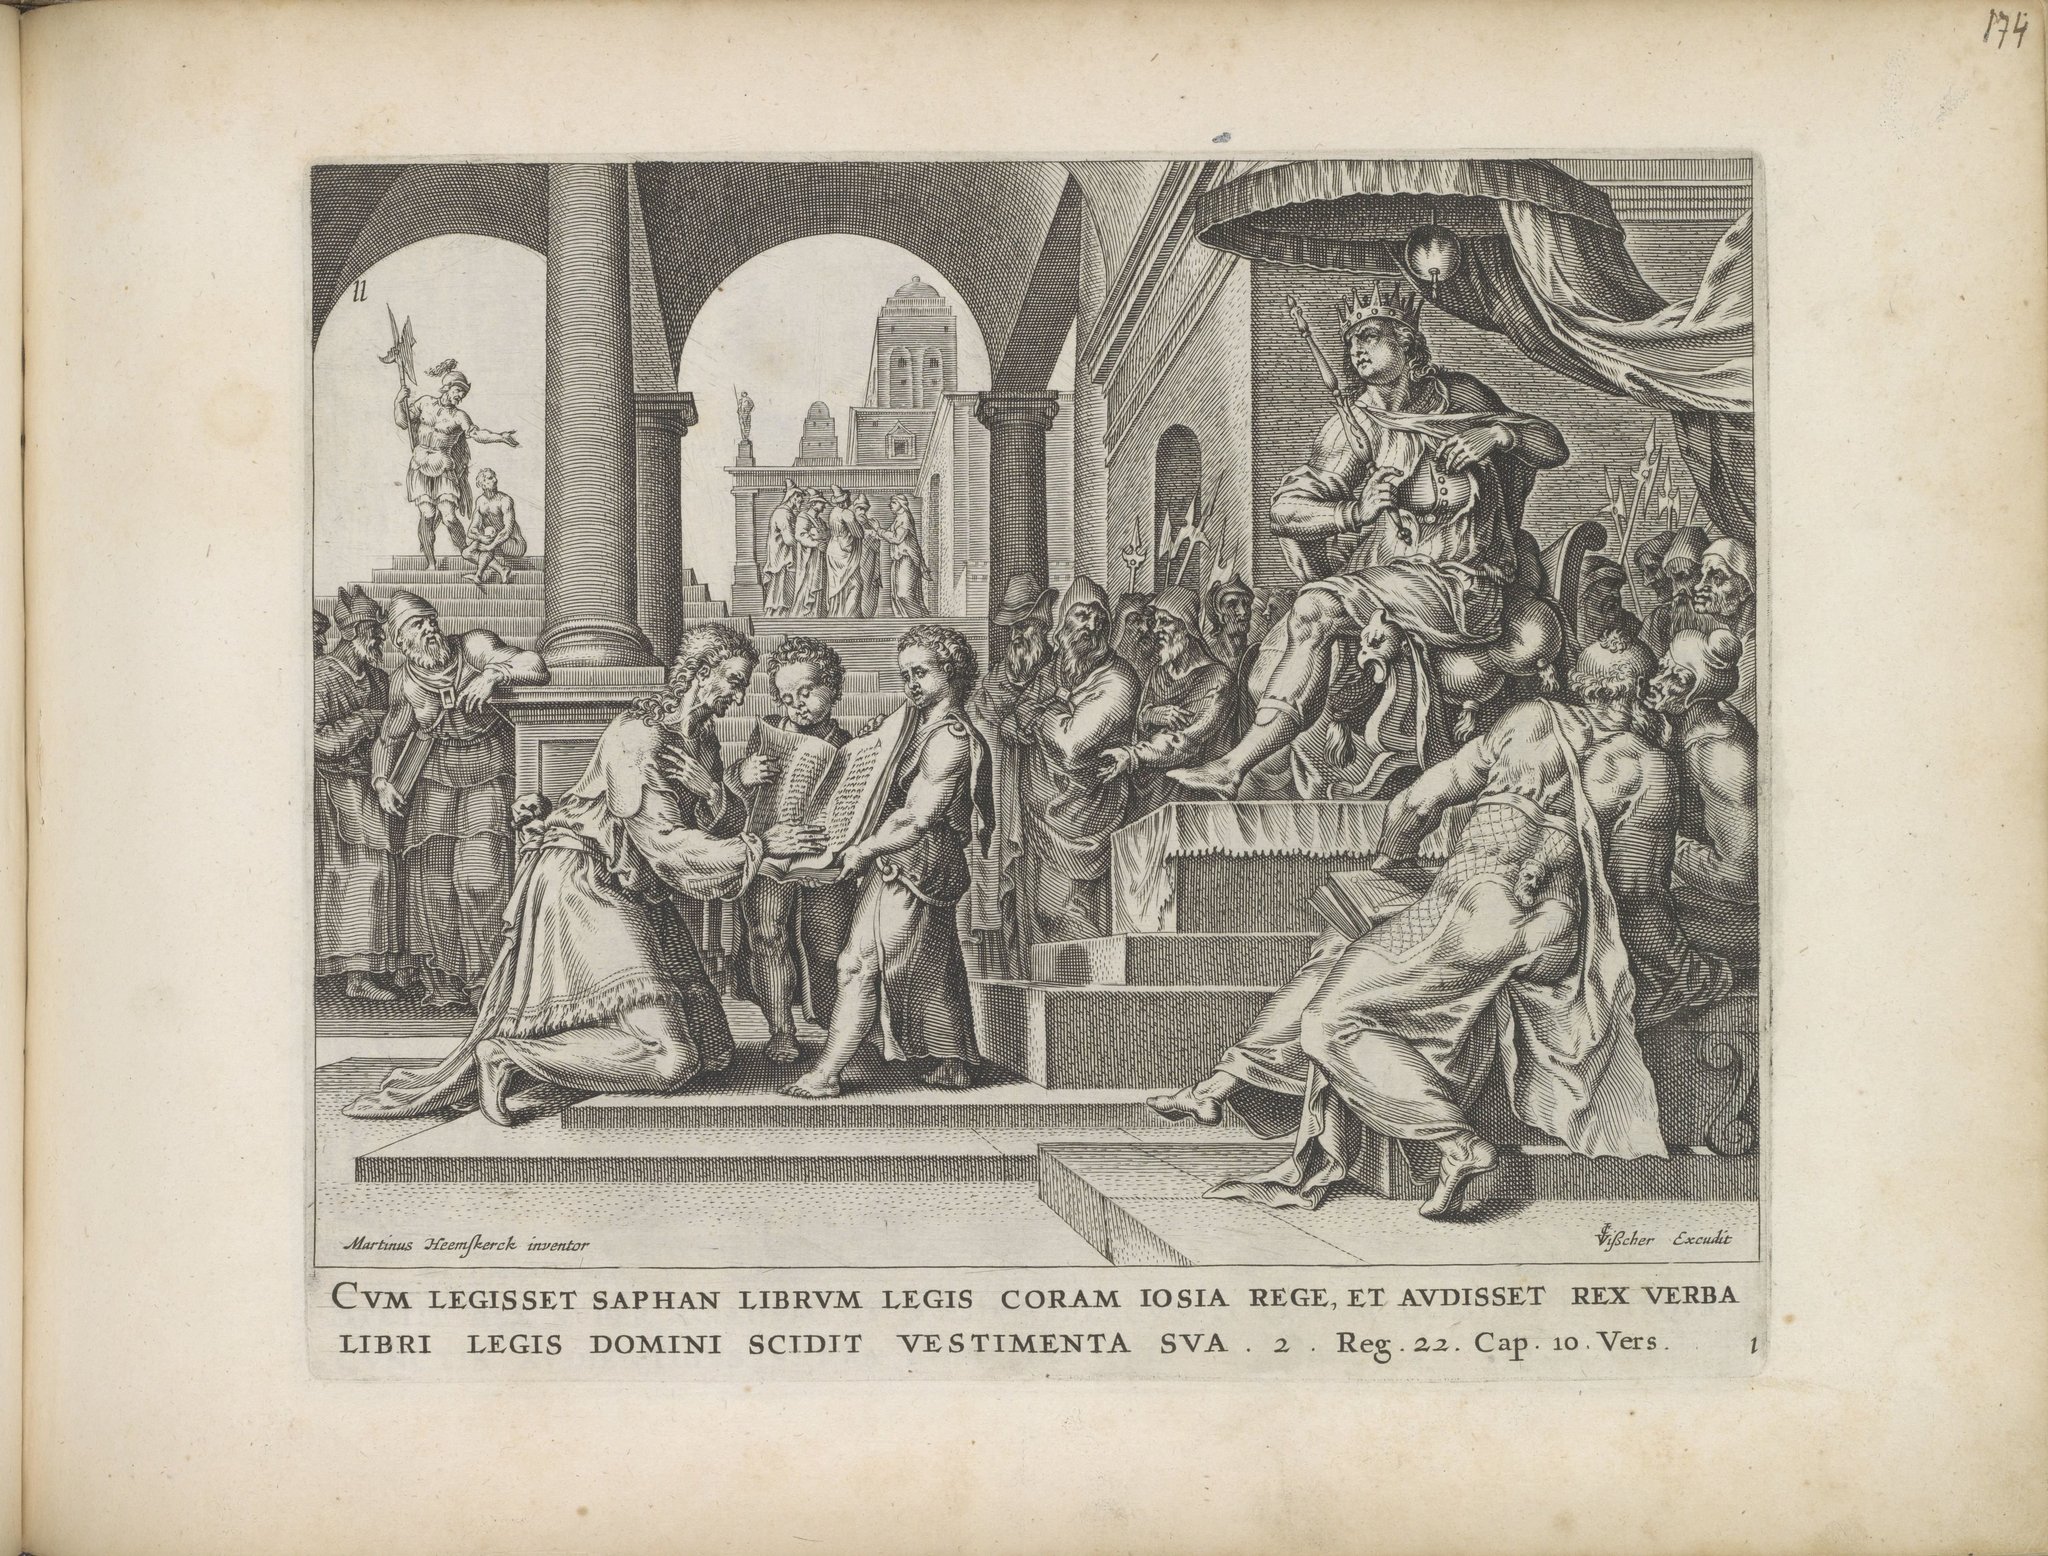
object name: album leaf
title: Theatrum Biblicum Hoc Est Historiae Sacrae Veteris et Novi Testamenti Tabulis Aeneis Expressae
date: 1643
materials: paper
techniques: engraving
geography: amsterdam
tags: saphan reads the book of law aloud to the king who tears his clothes in dismay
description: Koning Josia zit op zijn troon omgeven door leden van het hof. Voor hem knielt de hofschrijver Safan die hem voorleest uit een groot boek dat vastgehouden wordt door twee jongens. Bij het horen van de woorden uit de wet scheurt de koning zijn mantel. Onder de voorstelling een verwijzing in het Latijn naar de Bijbeltekst in 2 Kon. 22:10. Deze prent maakt deel uit van een album.